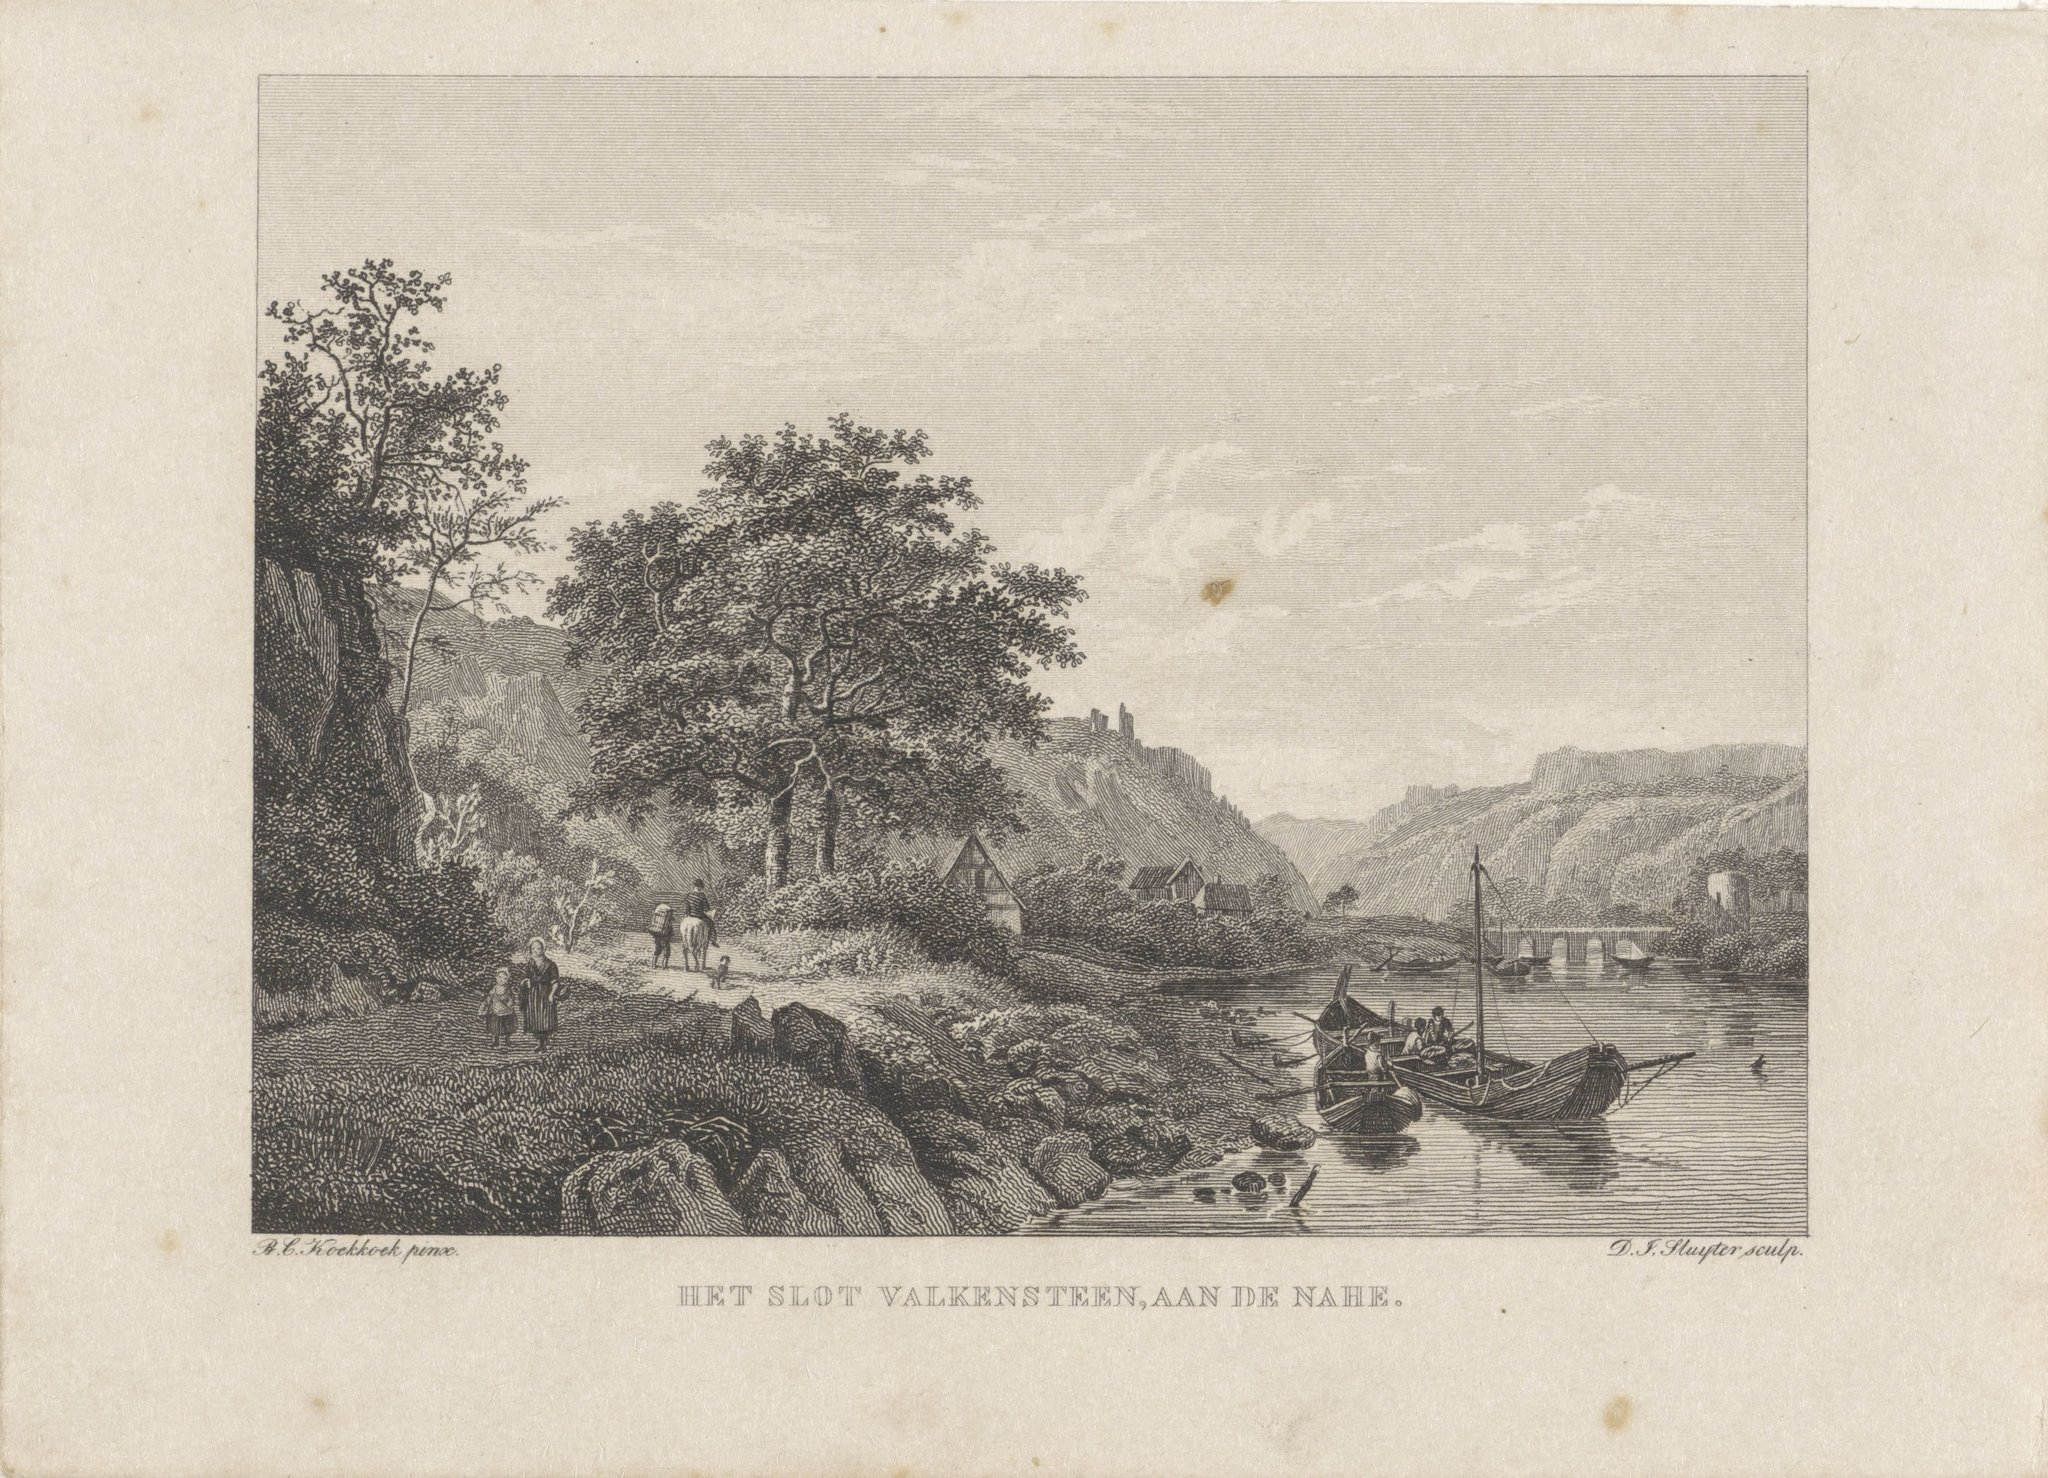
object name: print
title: Het slot Valkensteen, aan de Nahe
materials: paper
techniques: etching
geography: amsterdam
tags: river - hh - ideal landscapes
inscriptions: inscription: ‘Uit Tesselschade 1840’, collector's mark: Lugt 2228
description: Twee bootjes liggen voor anker in een rivier. Op de oever wandelen mensen. Op de achtergrond de ruïnes van een kasteel en enkele huizen.